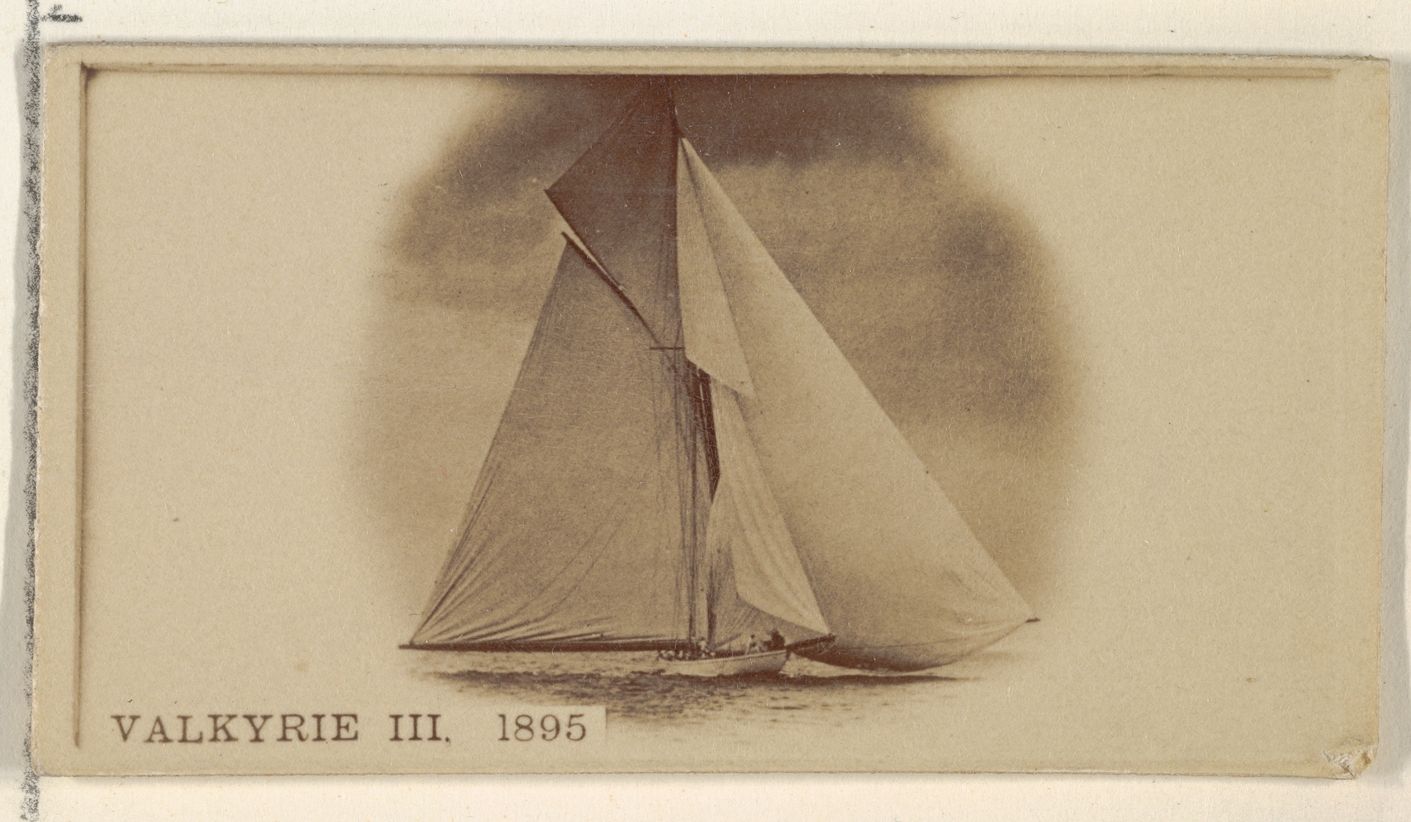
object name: photograph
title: Valkyrie III, 1895, from the Famous Ships series (N50) for Virginia Brights Cigarettes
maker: allen & ginter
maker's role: publisher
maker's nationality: american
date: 1895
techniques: albumen silver print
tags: boats